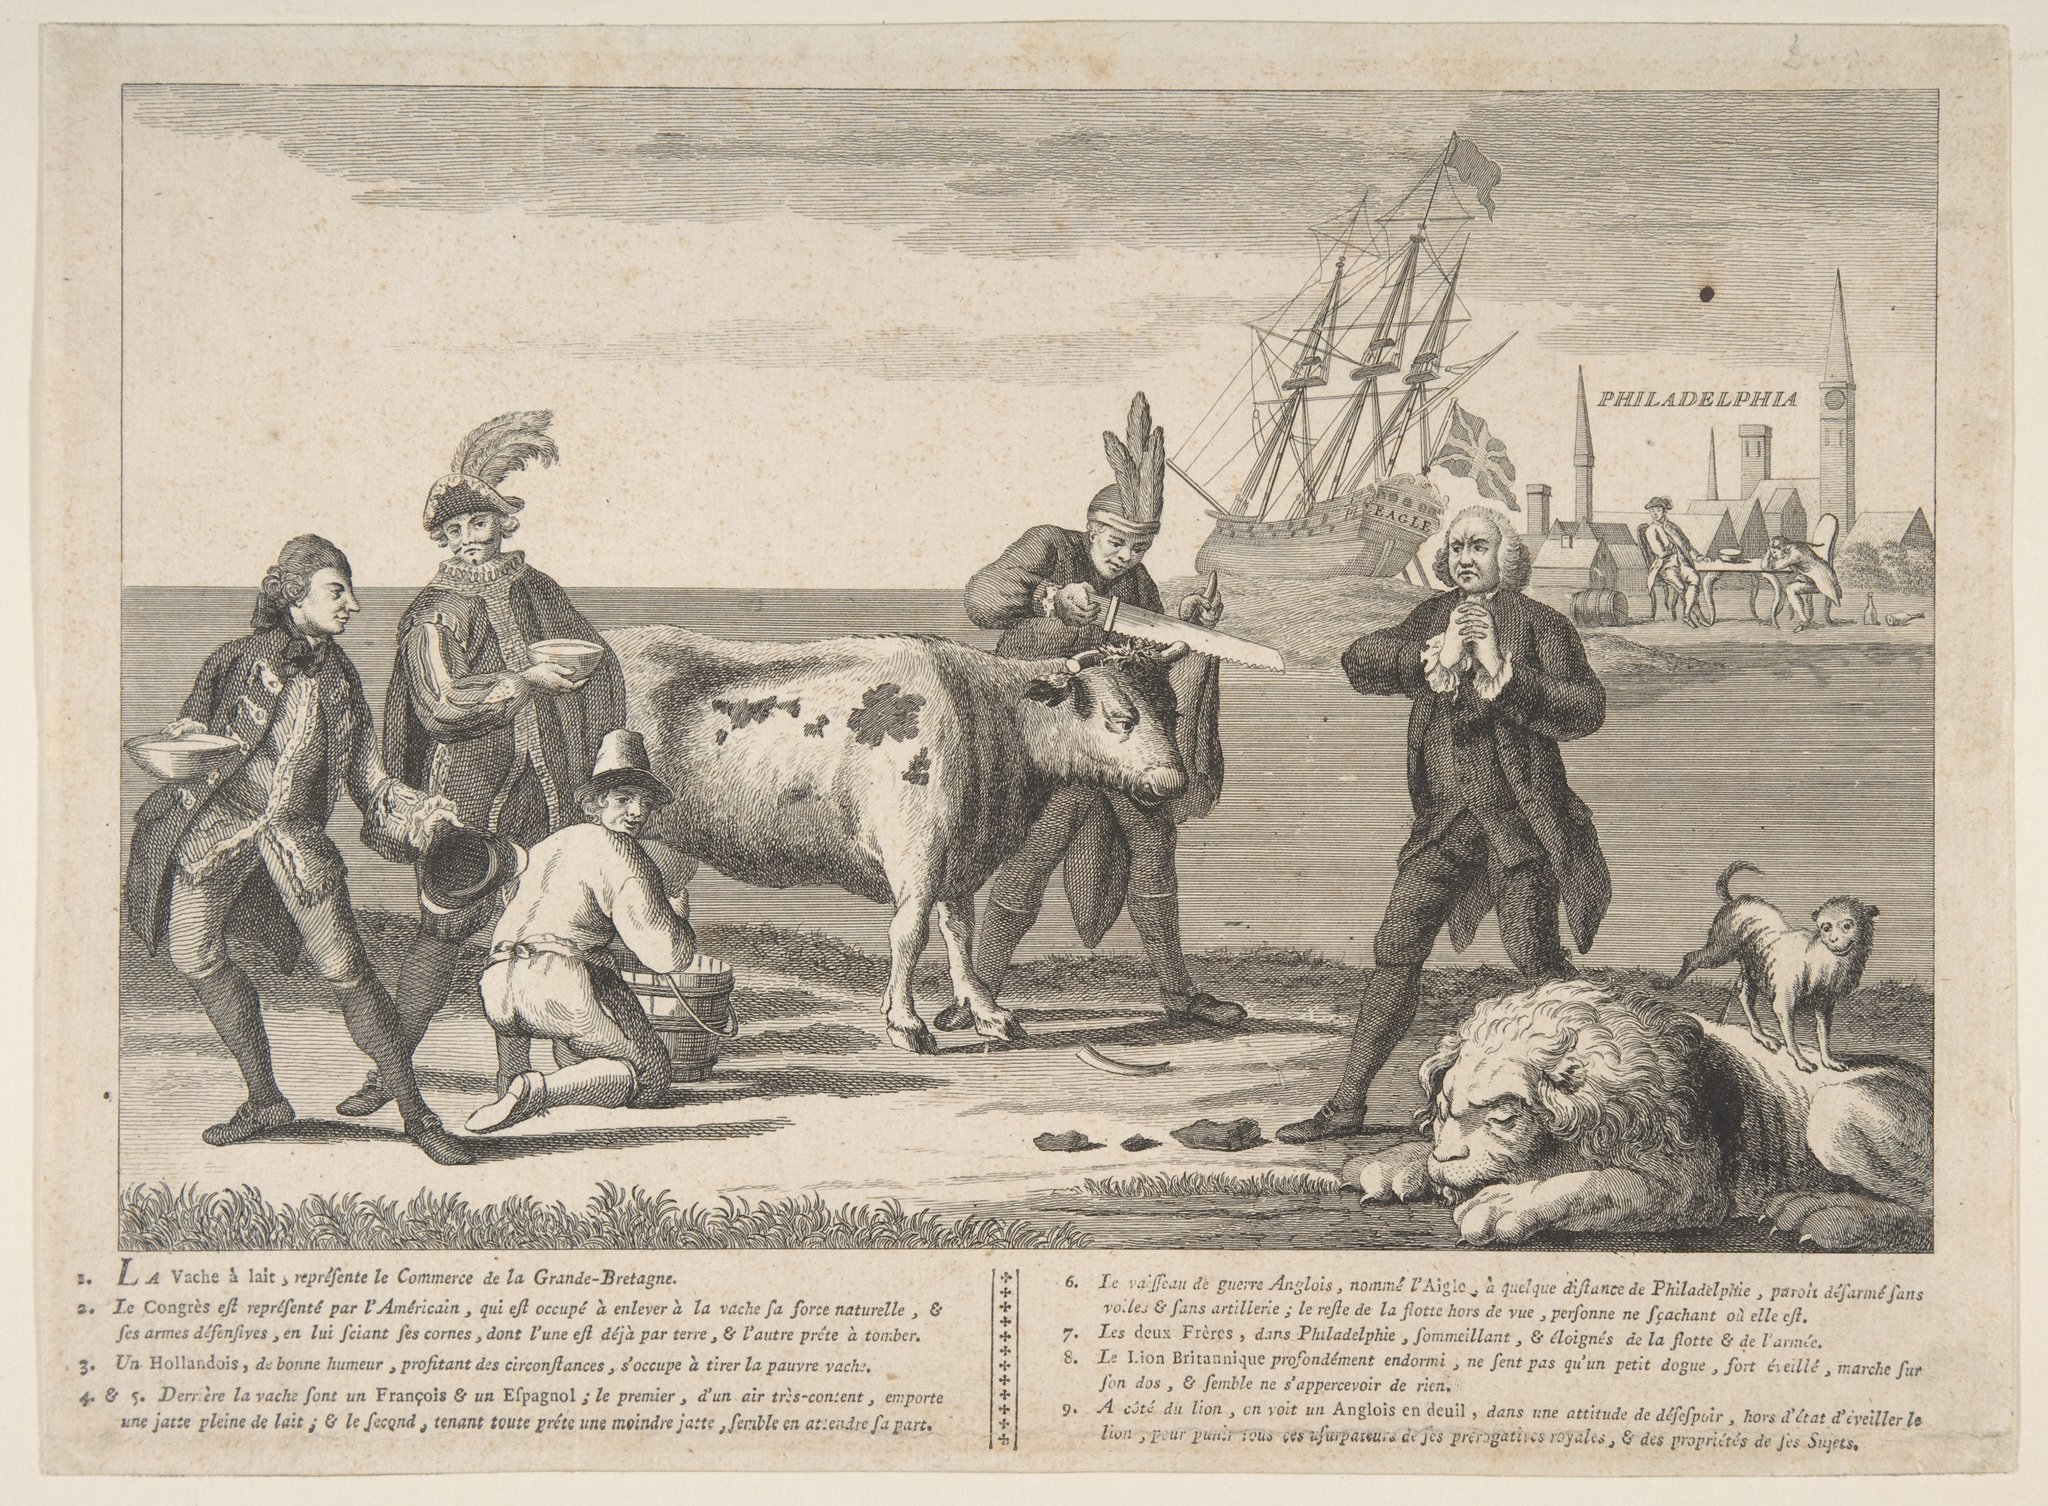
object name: print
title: State of the English Nation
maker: anonymous, british, 18th century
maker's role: artist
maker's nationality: british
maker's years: 1700-1800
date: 1780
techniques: engraving, etching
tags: satire,american revolution,men,cows,lions,politics